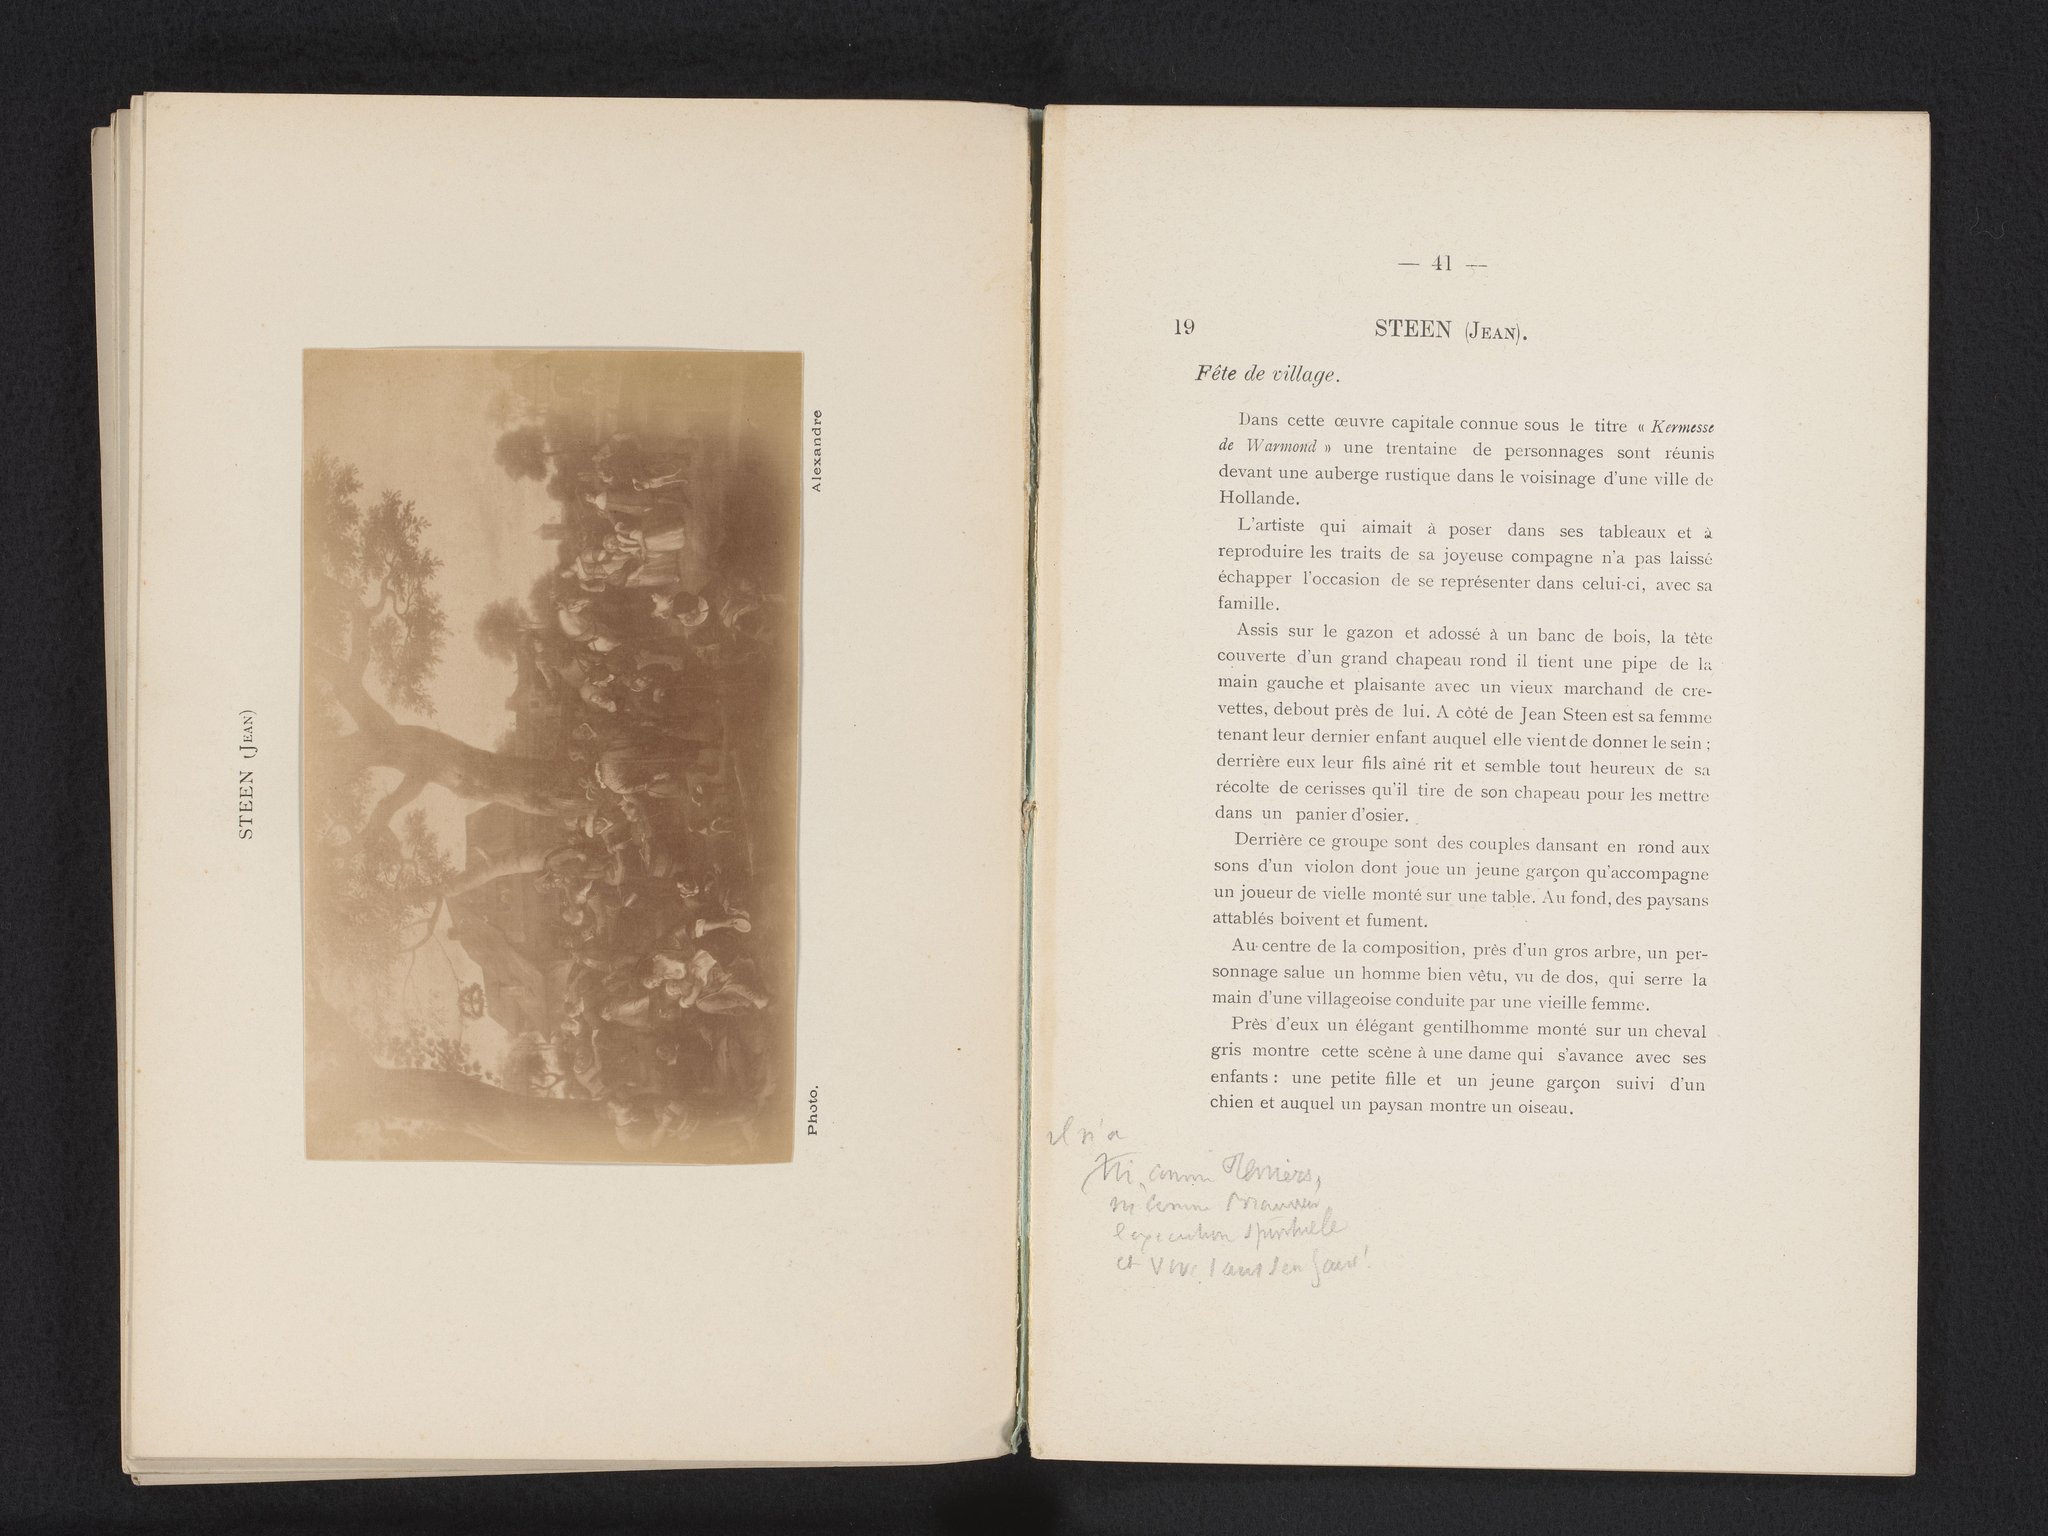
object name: page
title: Fotoreproductie van Dorpsfeest te Warmond door Jan Steen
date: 1878-1883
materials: photographic support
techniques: albumen print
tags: village (+ city(-scape) with figures, staffage), festivities, warmond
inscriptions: inscription: ‘Steen (Jean)’